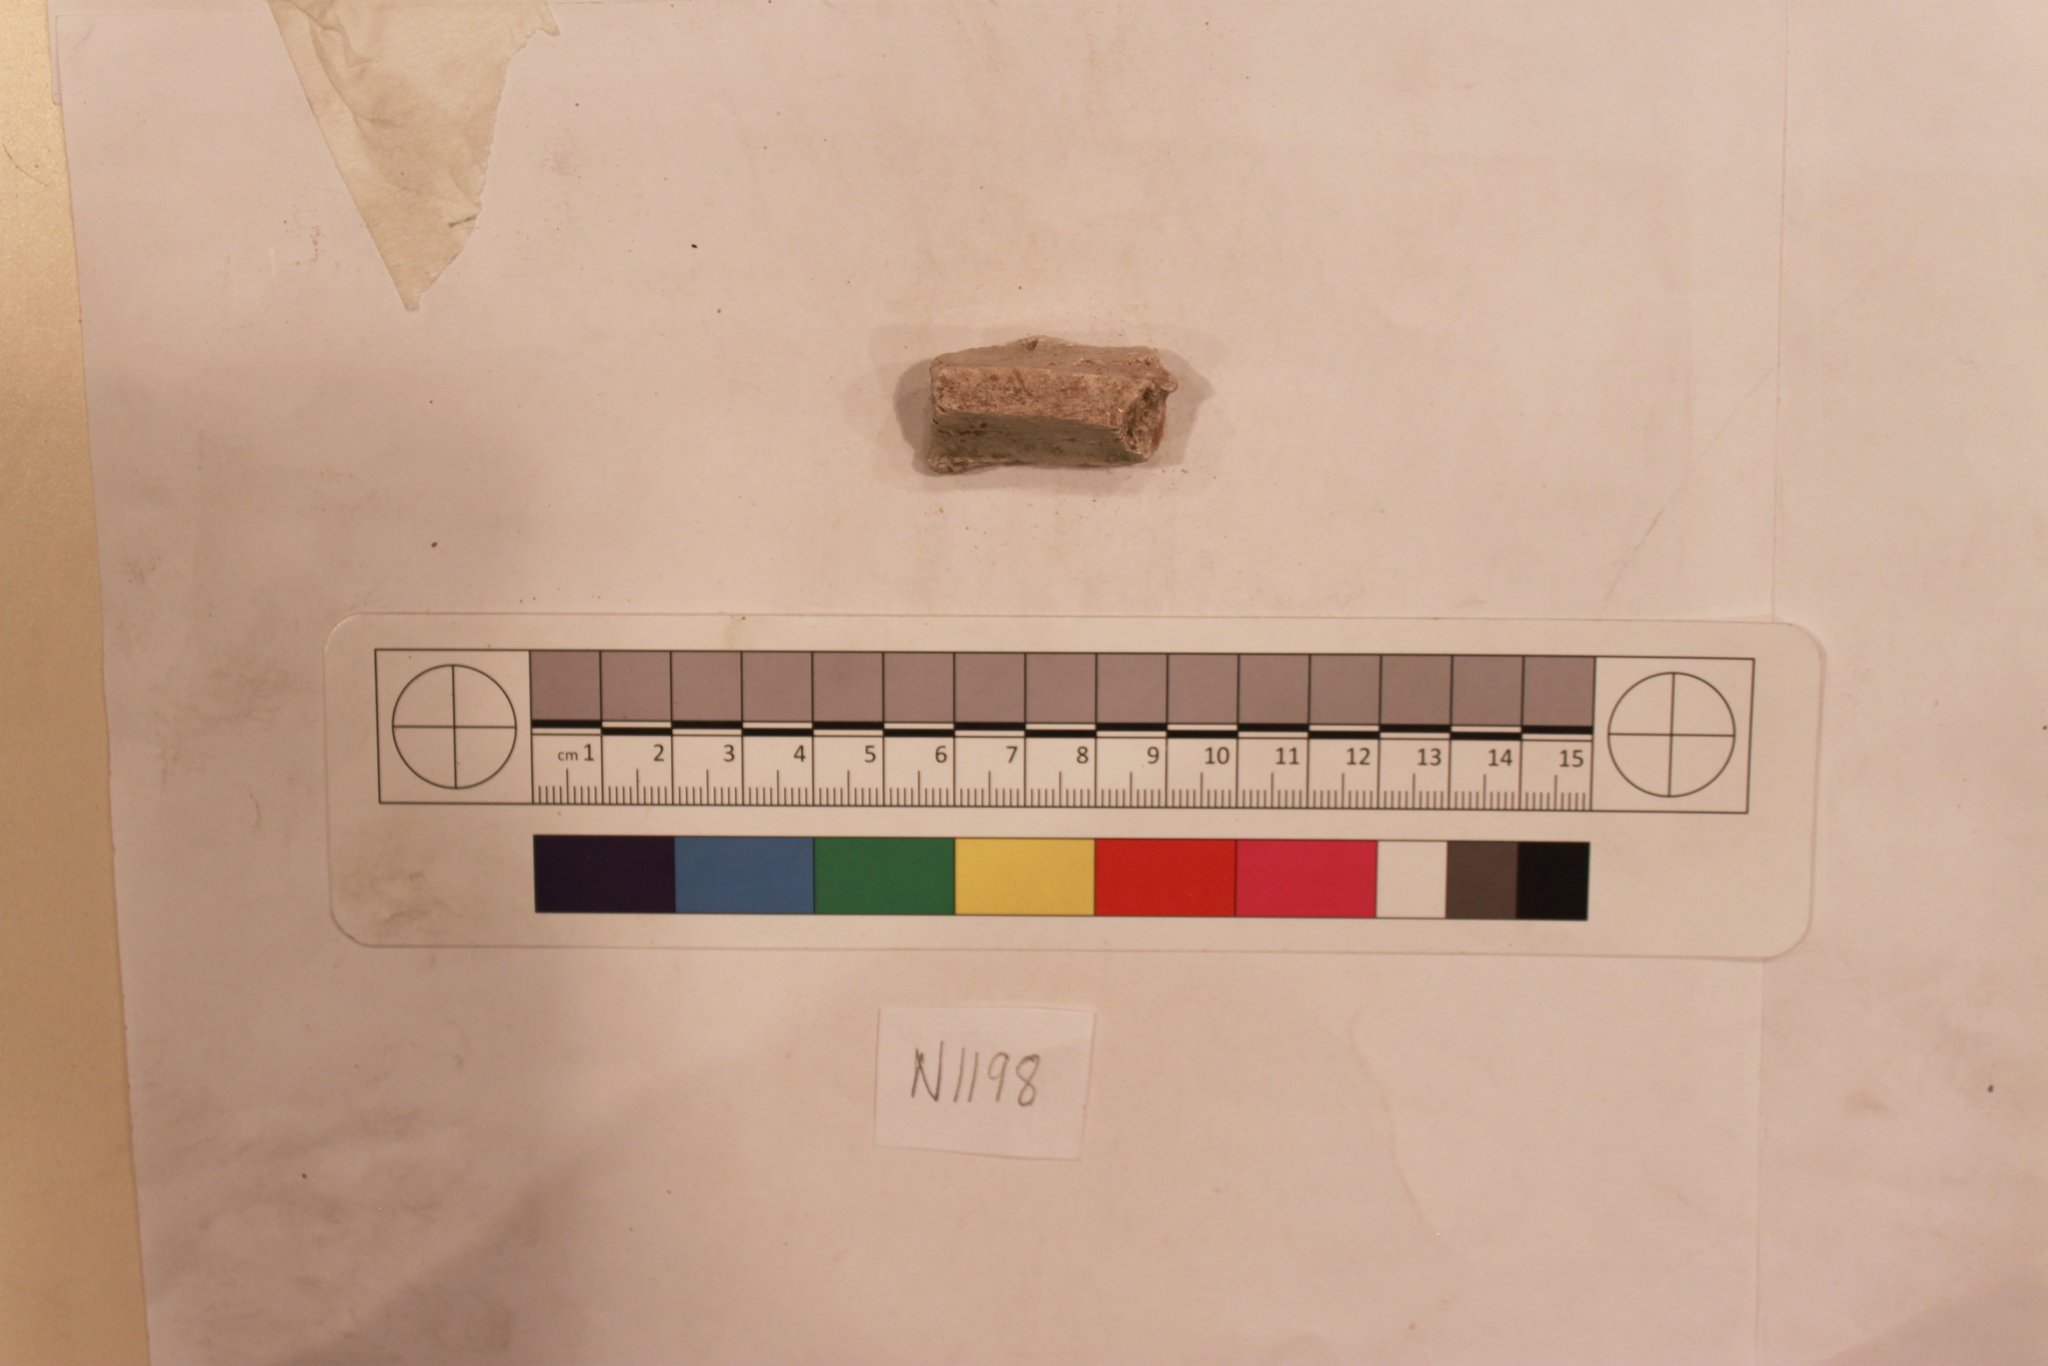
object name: fragment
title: Stucco Fragment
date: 701-1200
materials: plaster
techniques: carving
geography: iran